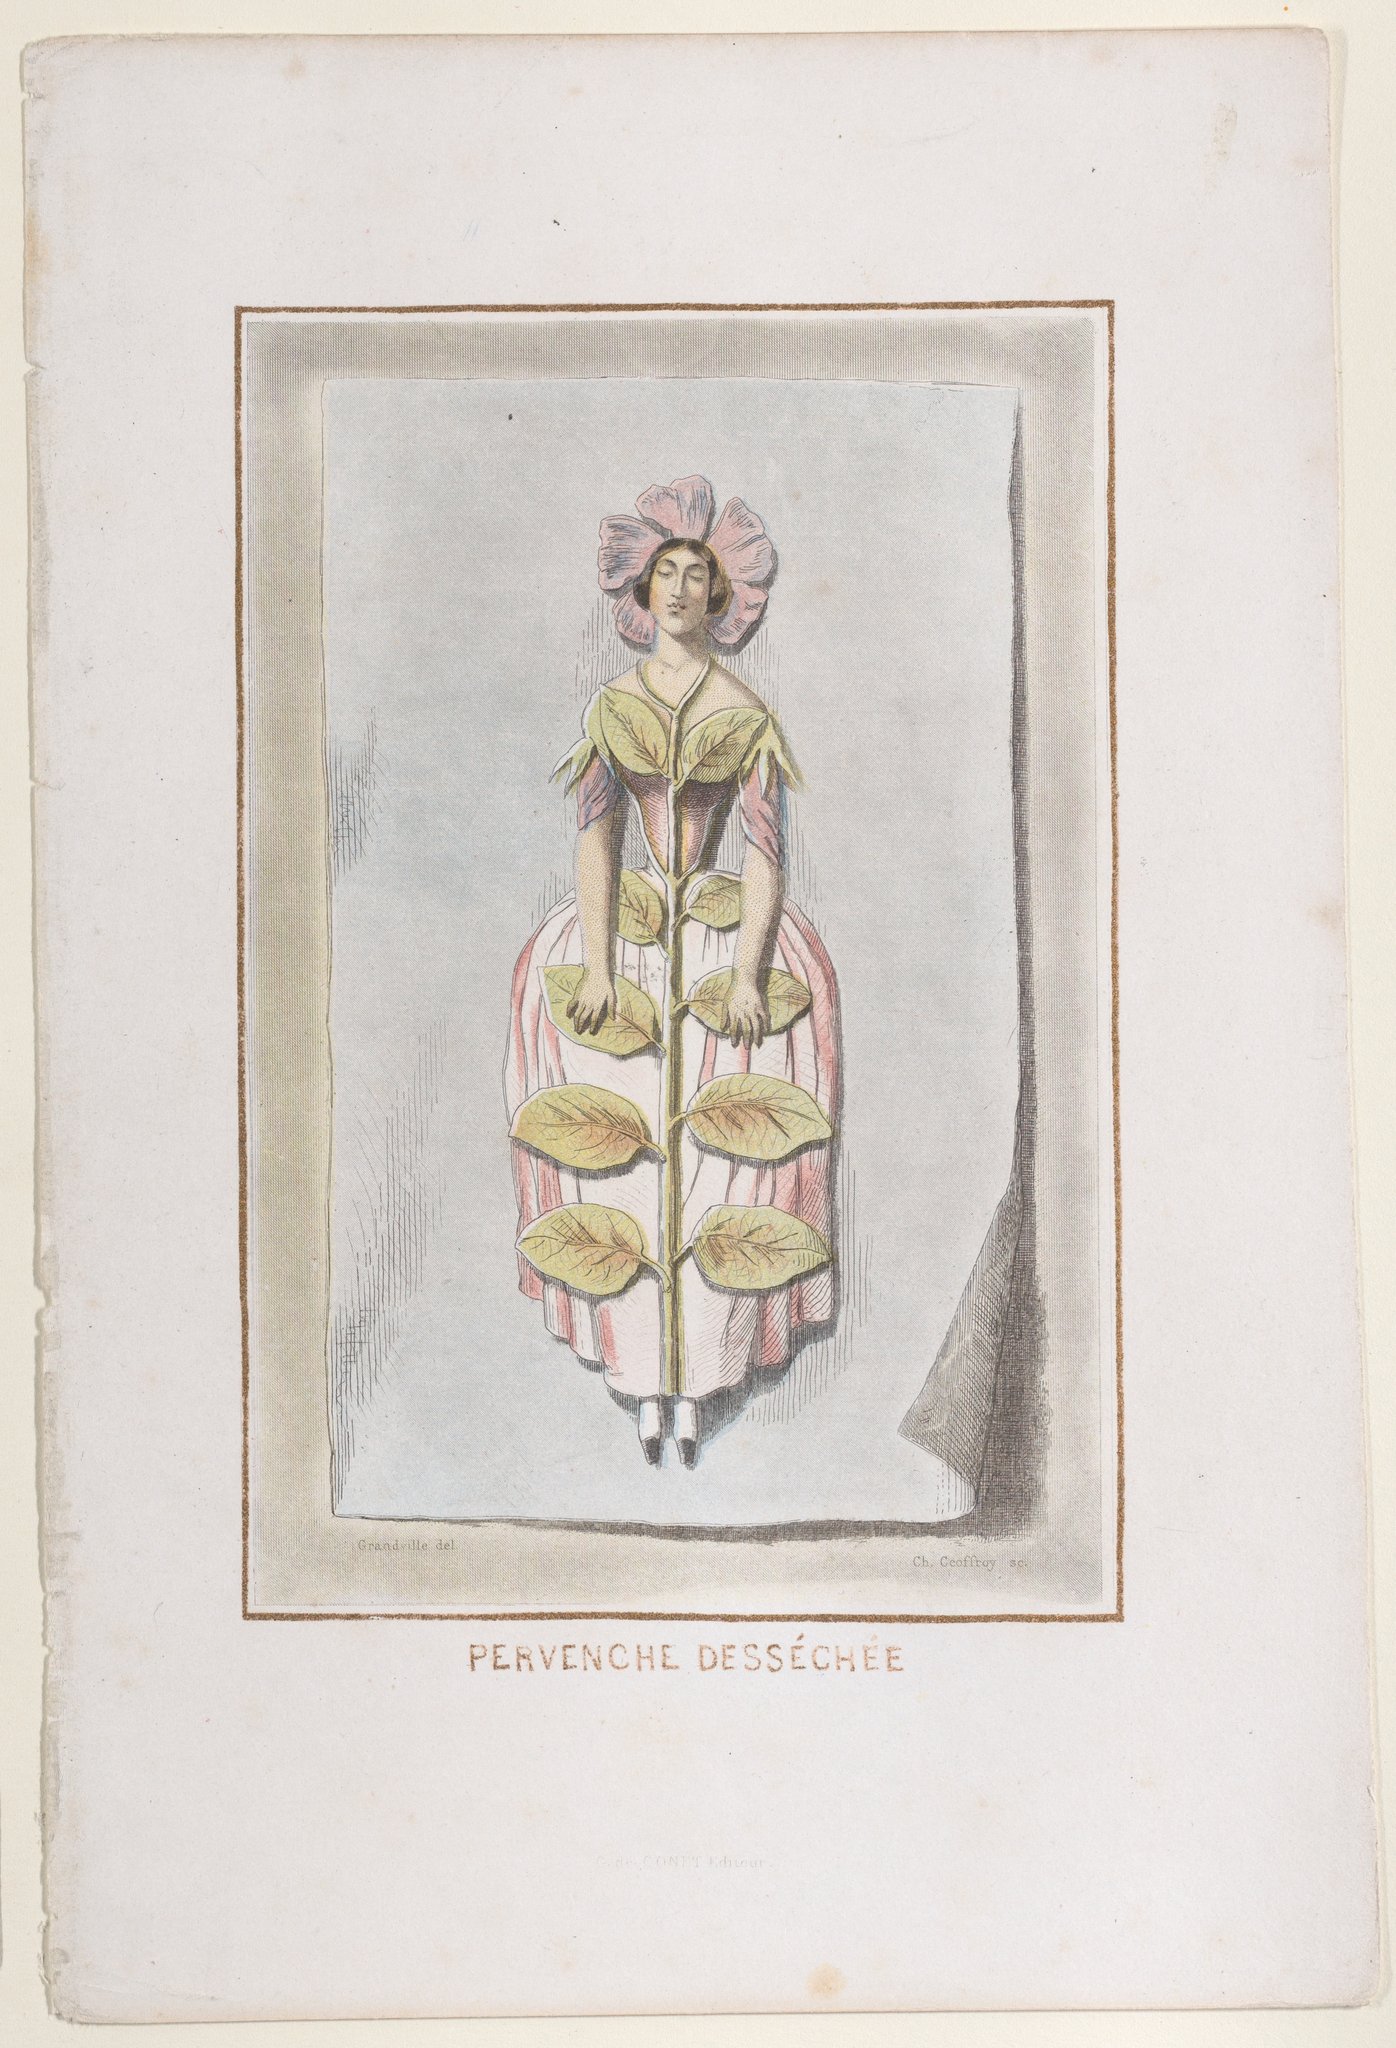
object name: print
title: Perveche Desséchée, from "Les Fleurs Animées"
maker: j. j. grandville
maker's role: designer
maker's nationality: french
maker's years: 1803-1847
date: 1847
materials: wood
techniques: engraving, hand coloring, lithograph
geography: paris